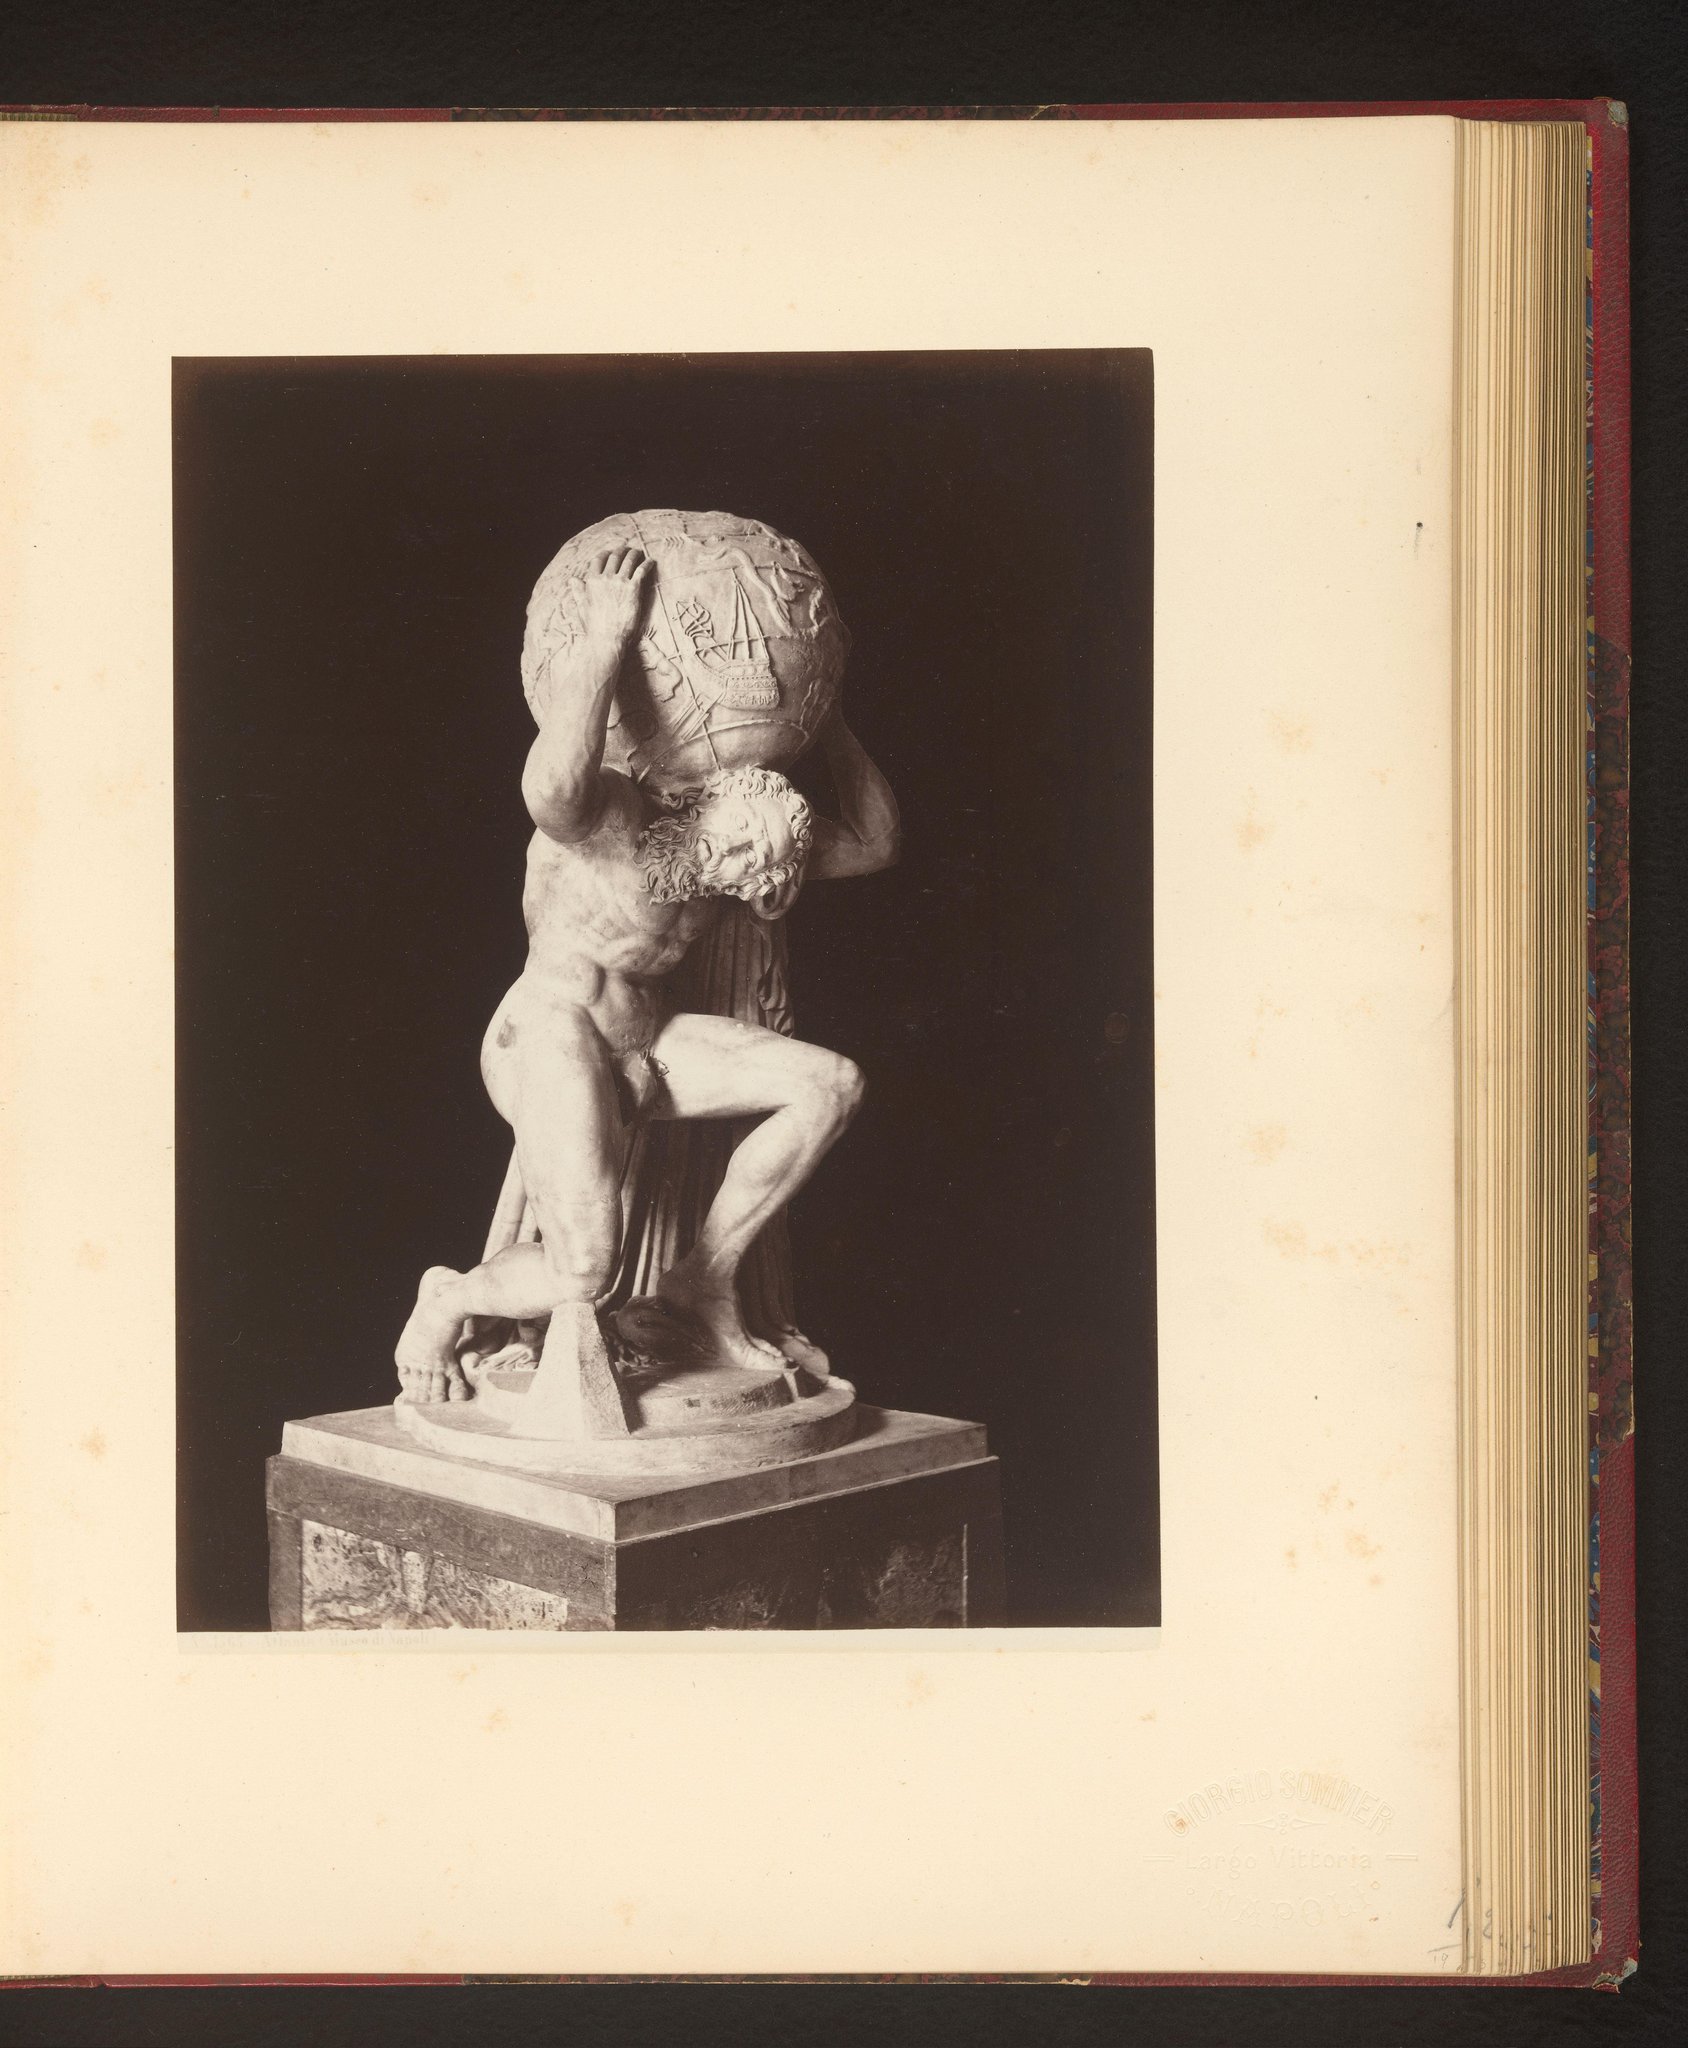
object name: photograph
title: Atlante Museo di Napoli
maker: giorgio sommer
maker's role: fotograaf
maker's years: 1834-1914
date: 1874-1879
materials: photographic support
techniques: albumen print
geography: naples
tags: (story of) atlas, sculpture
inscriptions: workshop stamp: ‘Giorgio Sommer/ Largo Vittoria/ Napoli’, number: ‘1[...]’